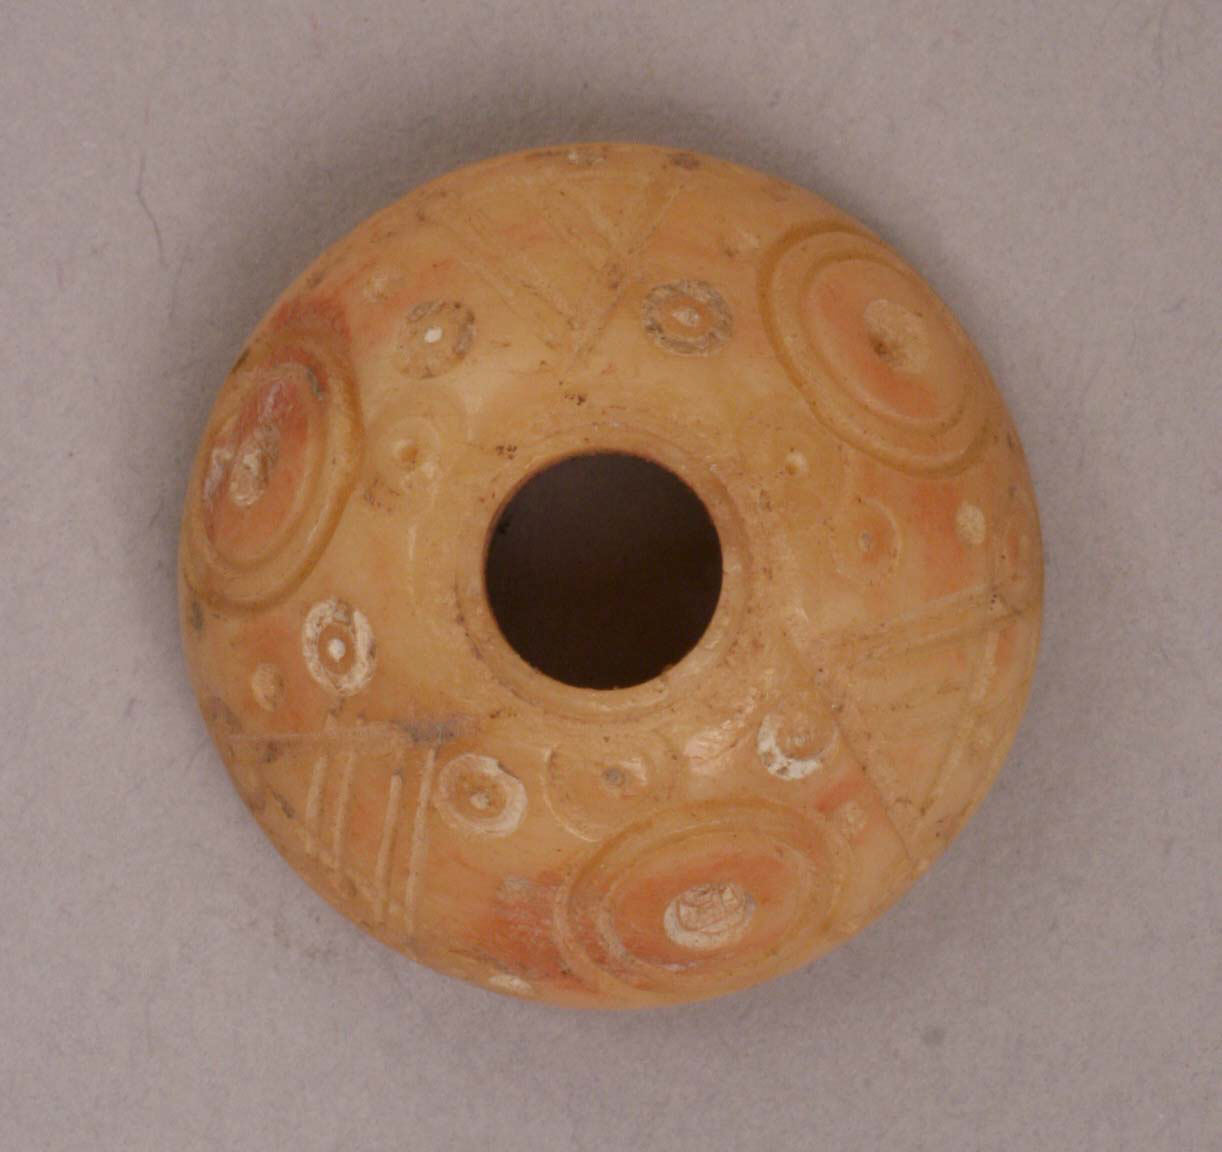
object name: button or bead or spindle whorl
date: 801-1000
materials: bone, paint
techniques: incising, inlay, tinting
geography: iran